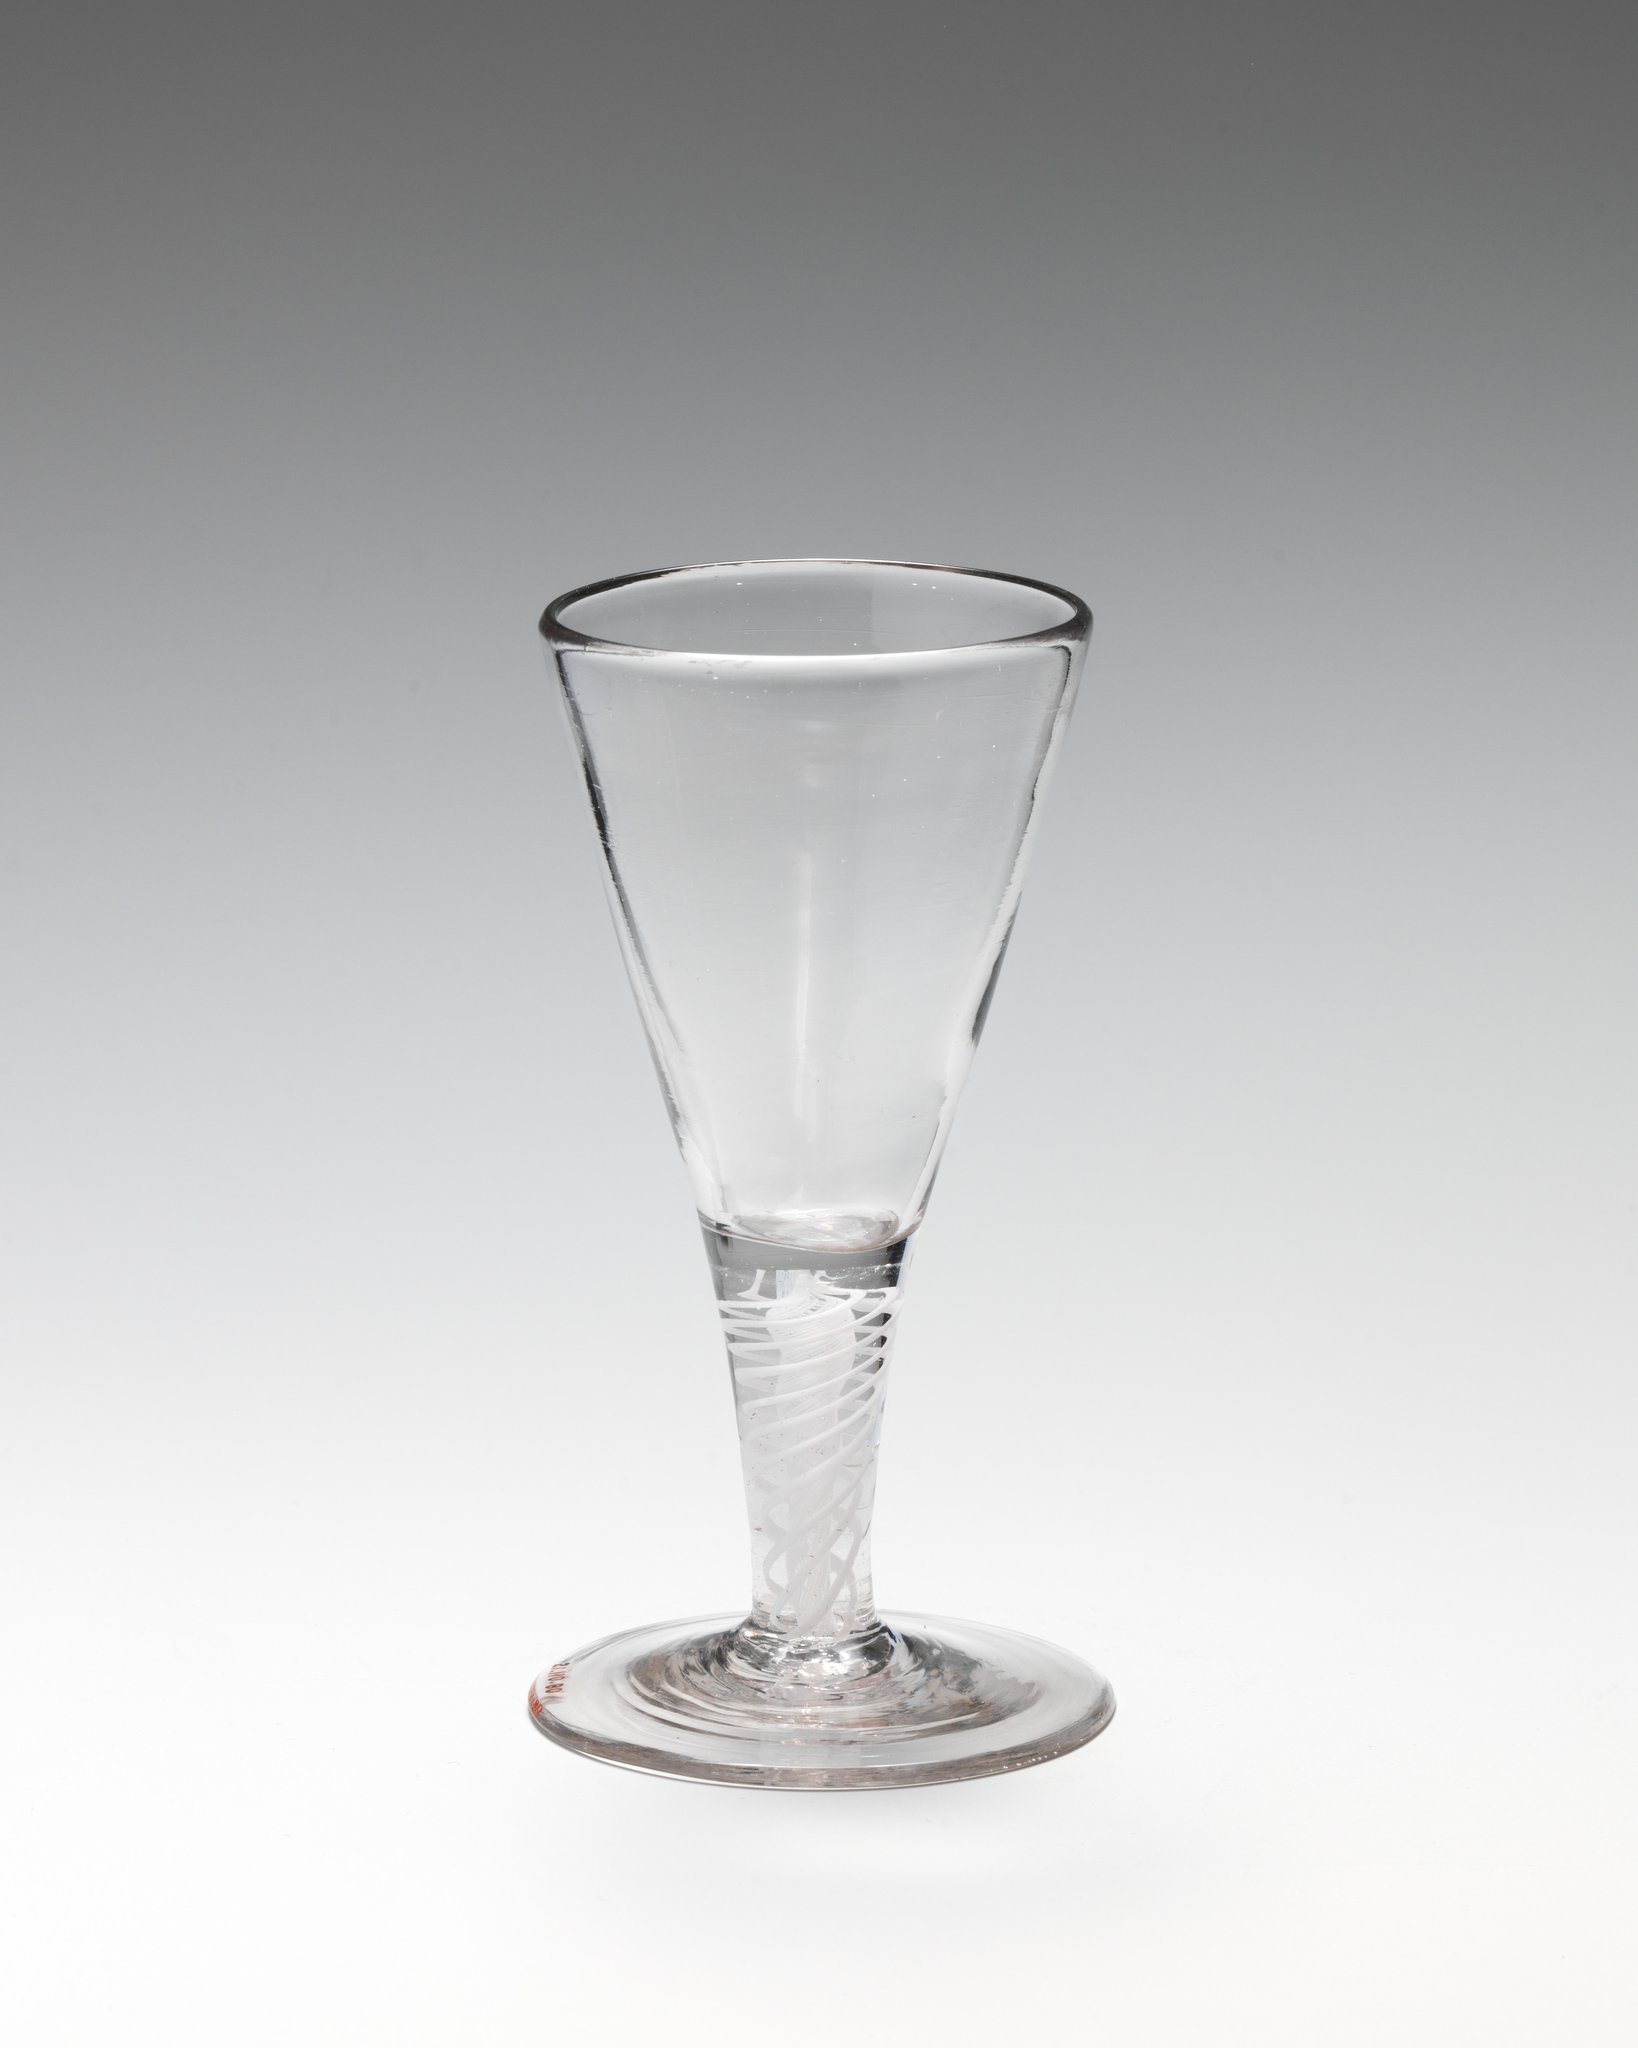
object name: wineglass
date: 1701-1800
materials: glass